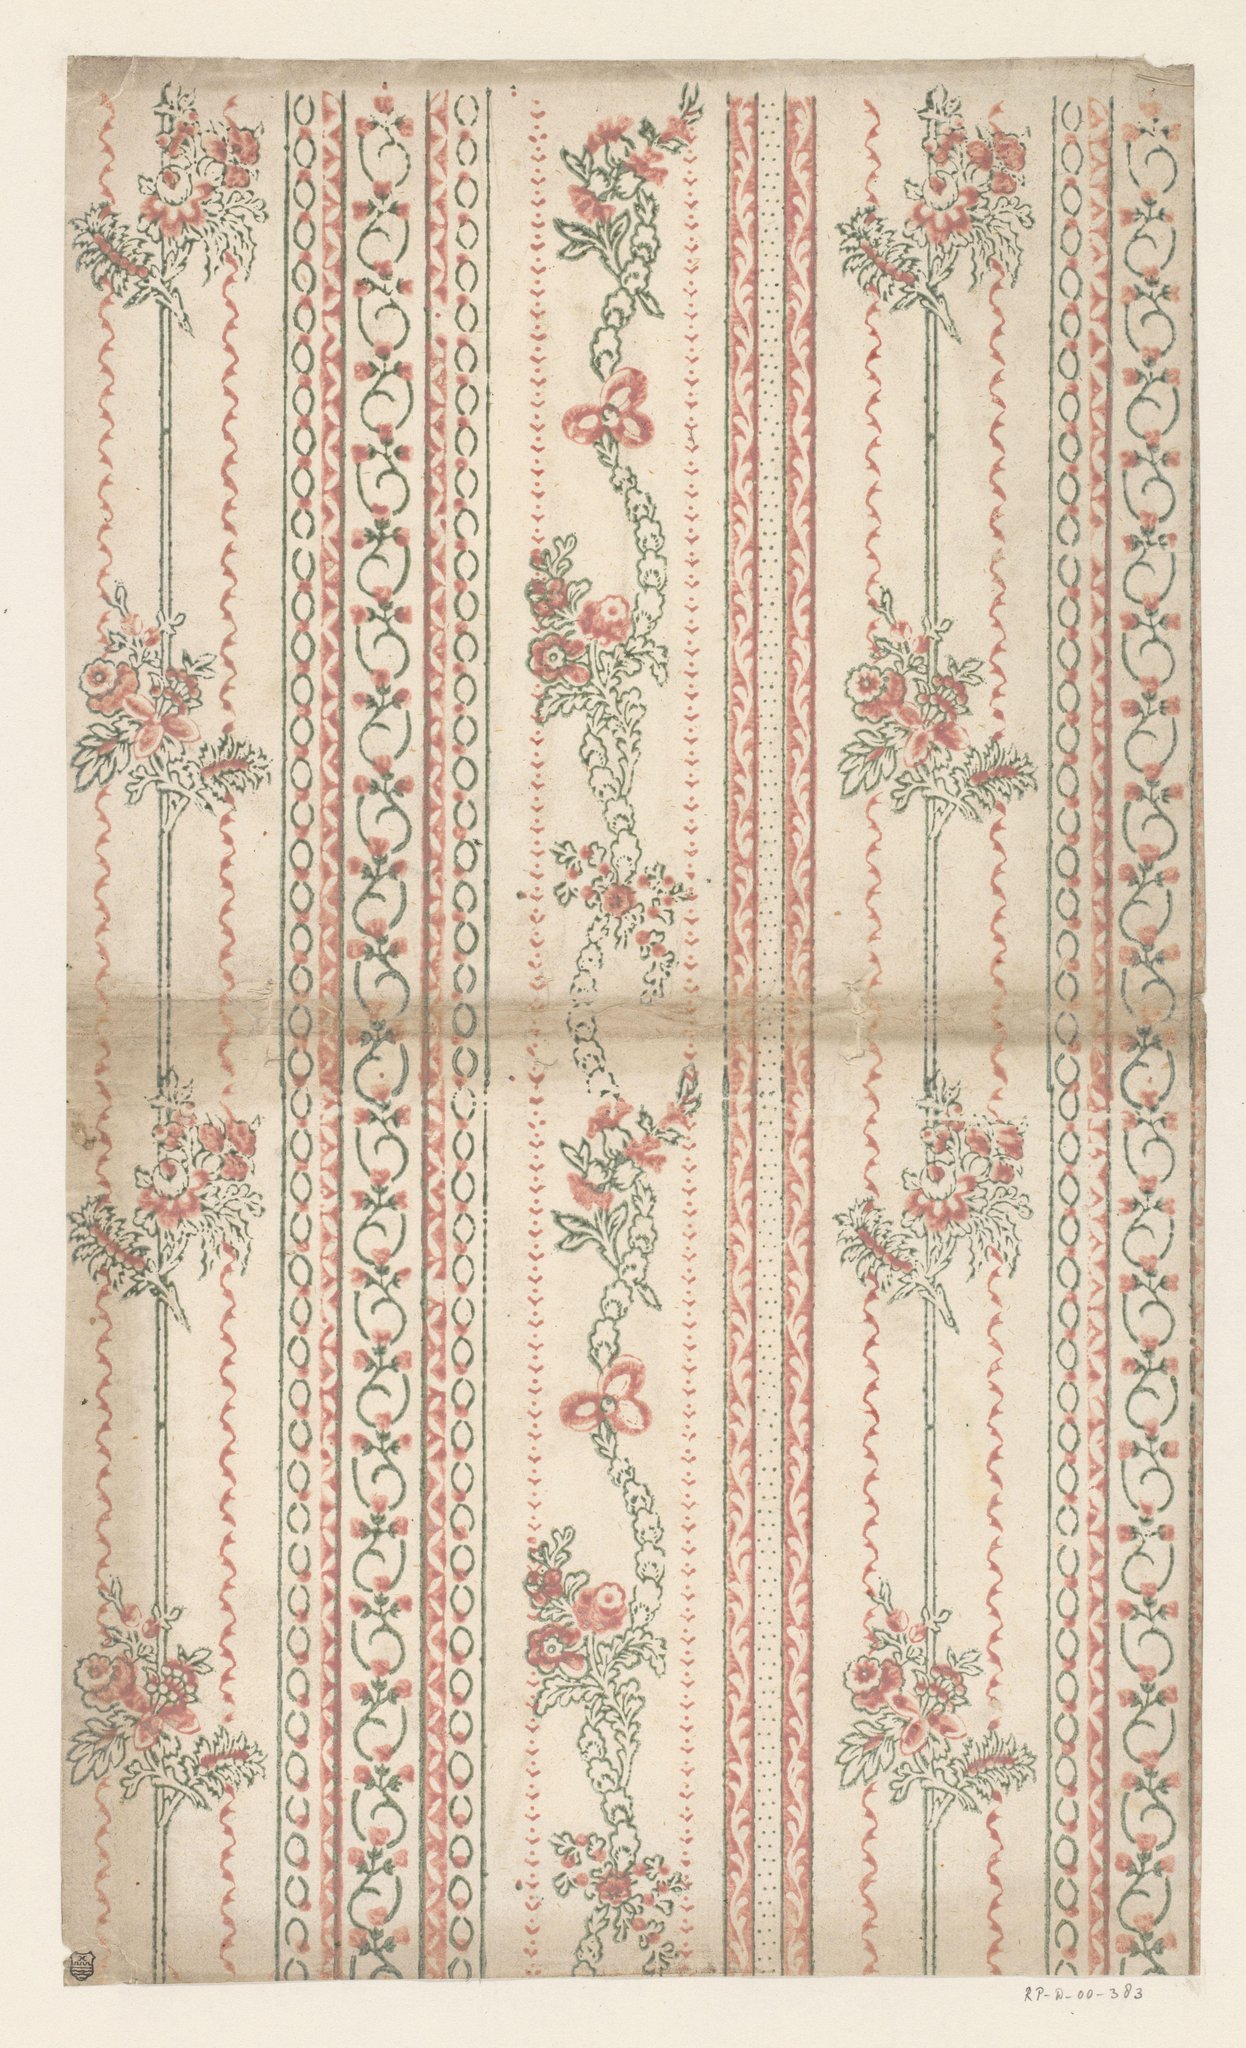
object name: wrapper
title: Blad met banenpatroon van festoenen met bloemen en sierlijsten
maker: Anonymous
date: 1700-1850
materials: paper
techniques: printing block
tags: ornament derived from plant forms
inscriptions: collector's mark: Lugt 2760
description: Blad met banenpatroon van festoenen met bloemen en sierlijsten. Gebruikt als omslag.